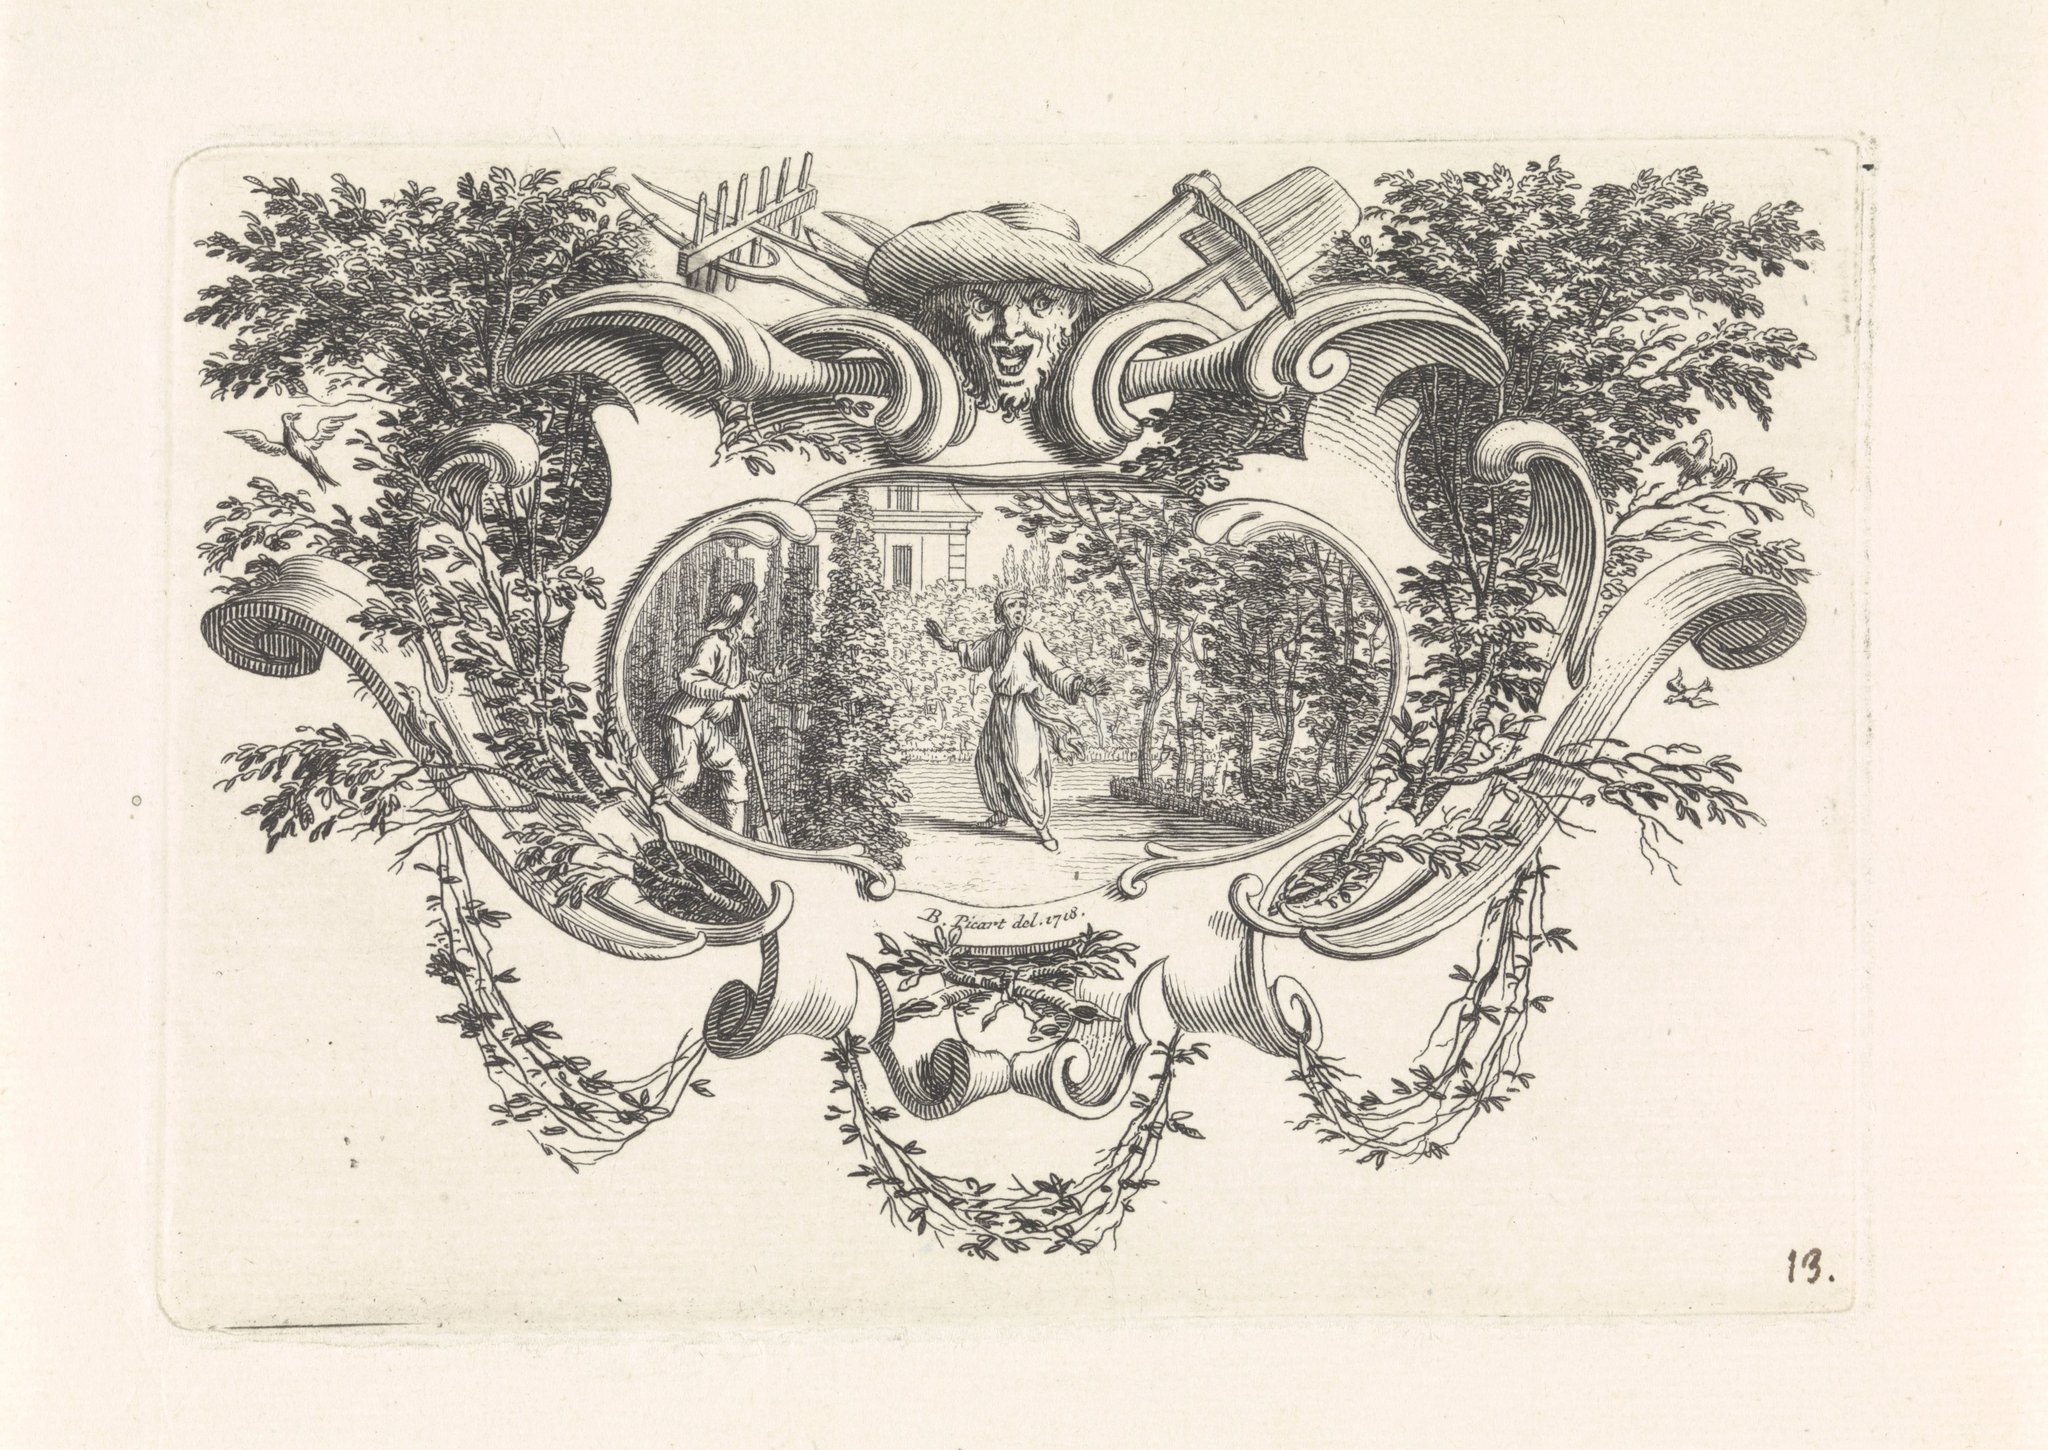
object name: print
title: Nicolas Boileau-Despréaux in een tuin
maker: bernard picart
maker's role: draughtsman, print maker, publisher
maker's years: 1673-1733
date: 1718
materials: paper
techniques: engraving, etching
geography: amsterdam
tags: paris, nicolas boileau, garden, gardening-tools, foliage, tendrils, branches ~ ornament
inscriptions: collector's mark: Lugt 2233, number: ‘13.’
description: De schrijver Nicolas Boileau-Despréaux staande in een tuin. Rechts een tuinman met zijn schop. De voorstelling is gevat in een ornamentele lijst met midden boven het gezicht van een tuinman en tuinwerktuigen.